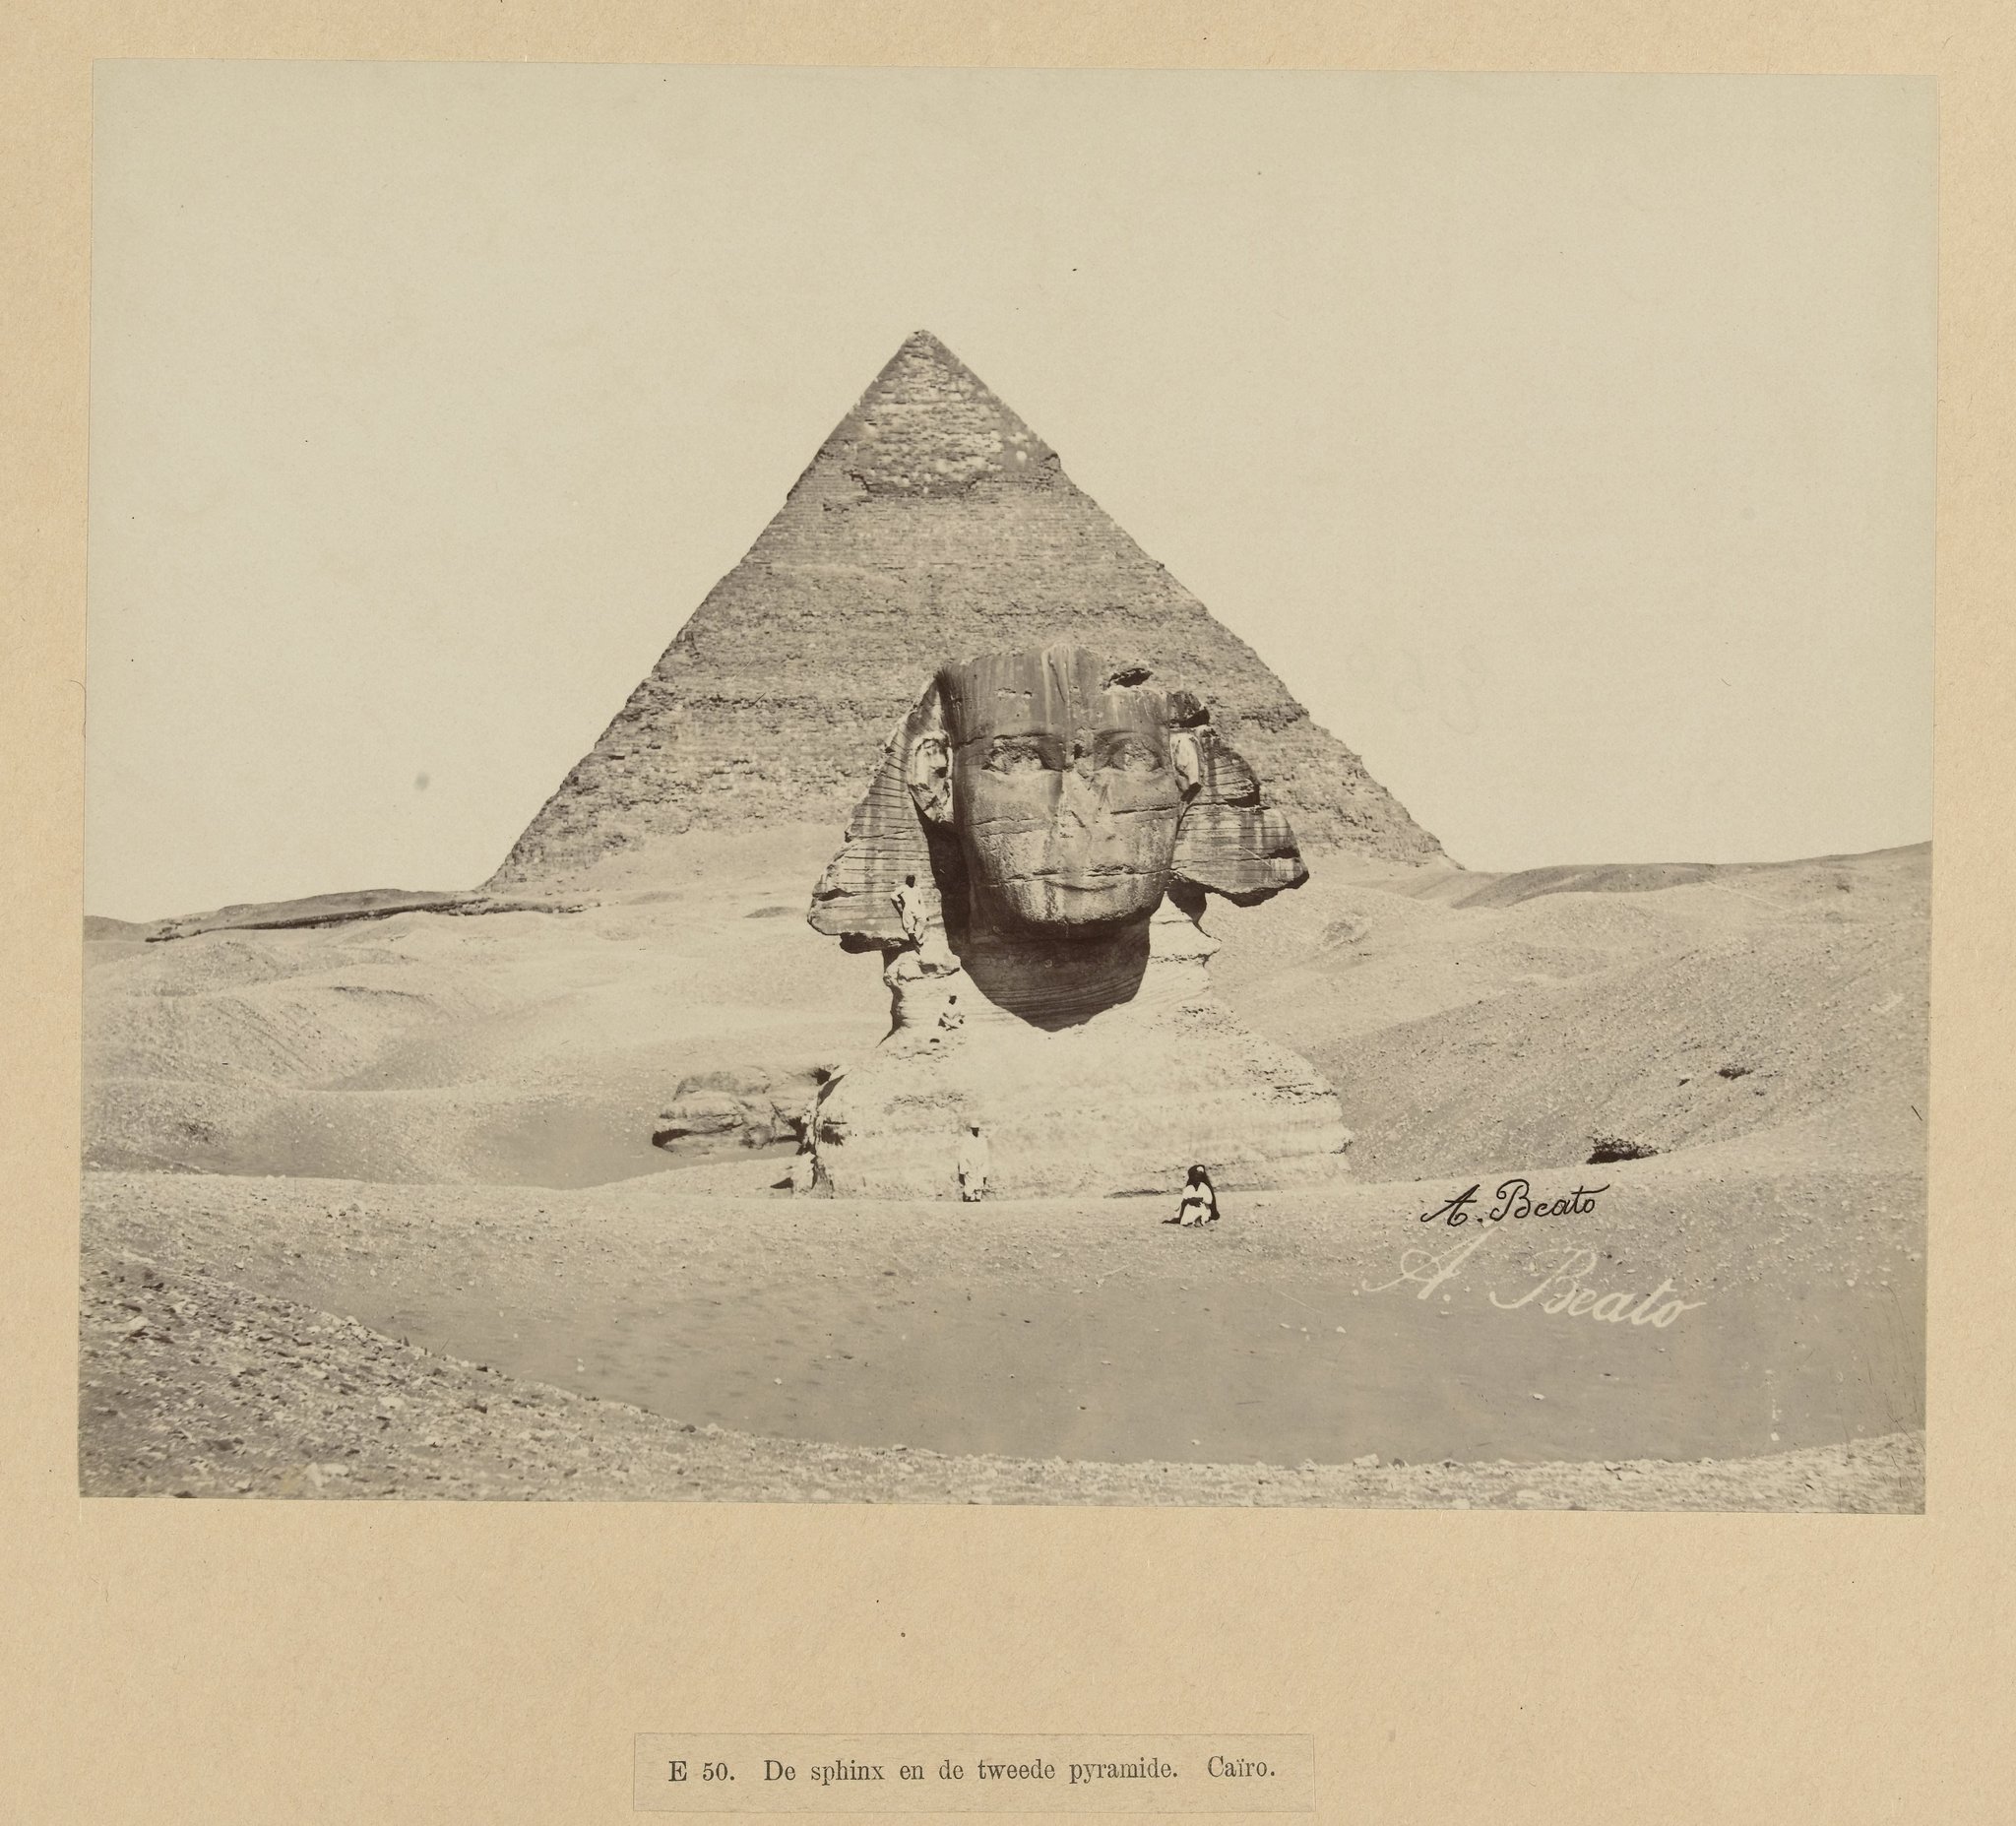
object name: photograph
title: E 50. De sphinx en de tweede pyramide. Caïro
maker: antonio beato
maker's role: fotograaf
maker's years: 1835-1906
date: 1862-1880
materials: cardboard, paper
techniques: albumen print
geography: gizeh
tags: sphinx (lion/woman); 'sfinge' (ripa), pyramid (historical grave form)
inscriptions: title: ‘E 50. De sphinx en de tweede pyramide. Caïro.’, stamp: ‘Gemeentelijke bibliotheek/ Rotterdam’, check stamp: ‘Bristol/ L.M.’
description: Onderdeel van een groep door fotograaf Richard Polak op reis verzamelde foto’s. Deze foto is samen met andere op zijn reizen verzamelde foto's tentoongesteld bij de Rotterdamsche Kunstkring (1895), Arti en Amicitiae te Amsterdam (1897-1898?) en Societeit 't Collegie te Kampen (datum vooralsnog onbekend).